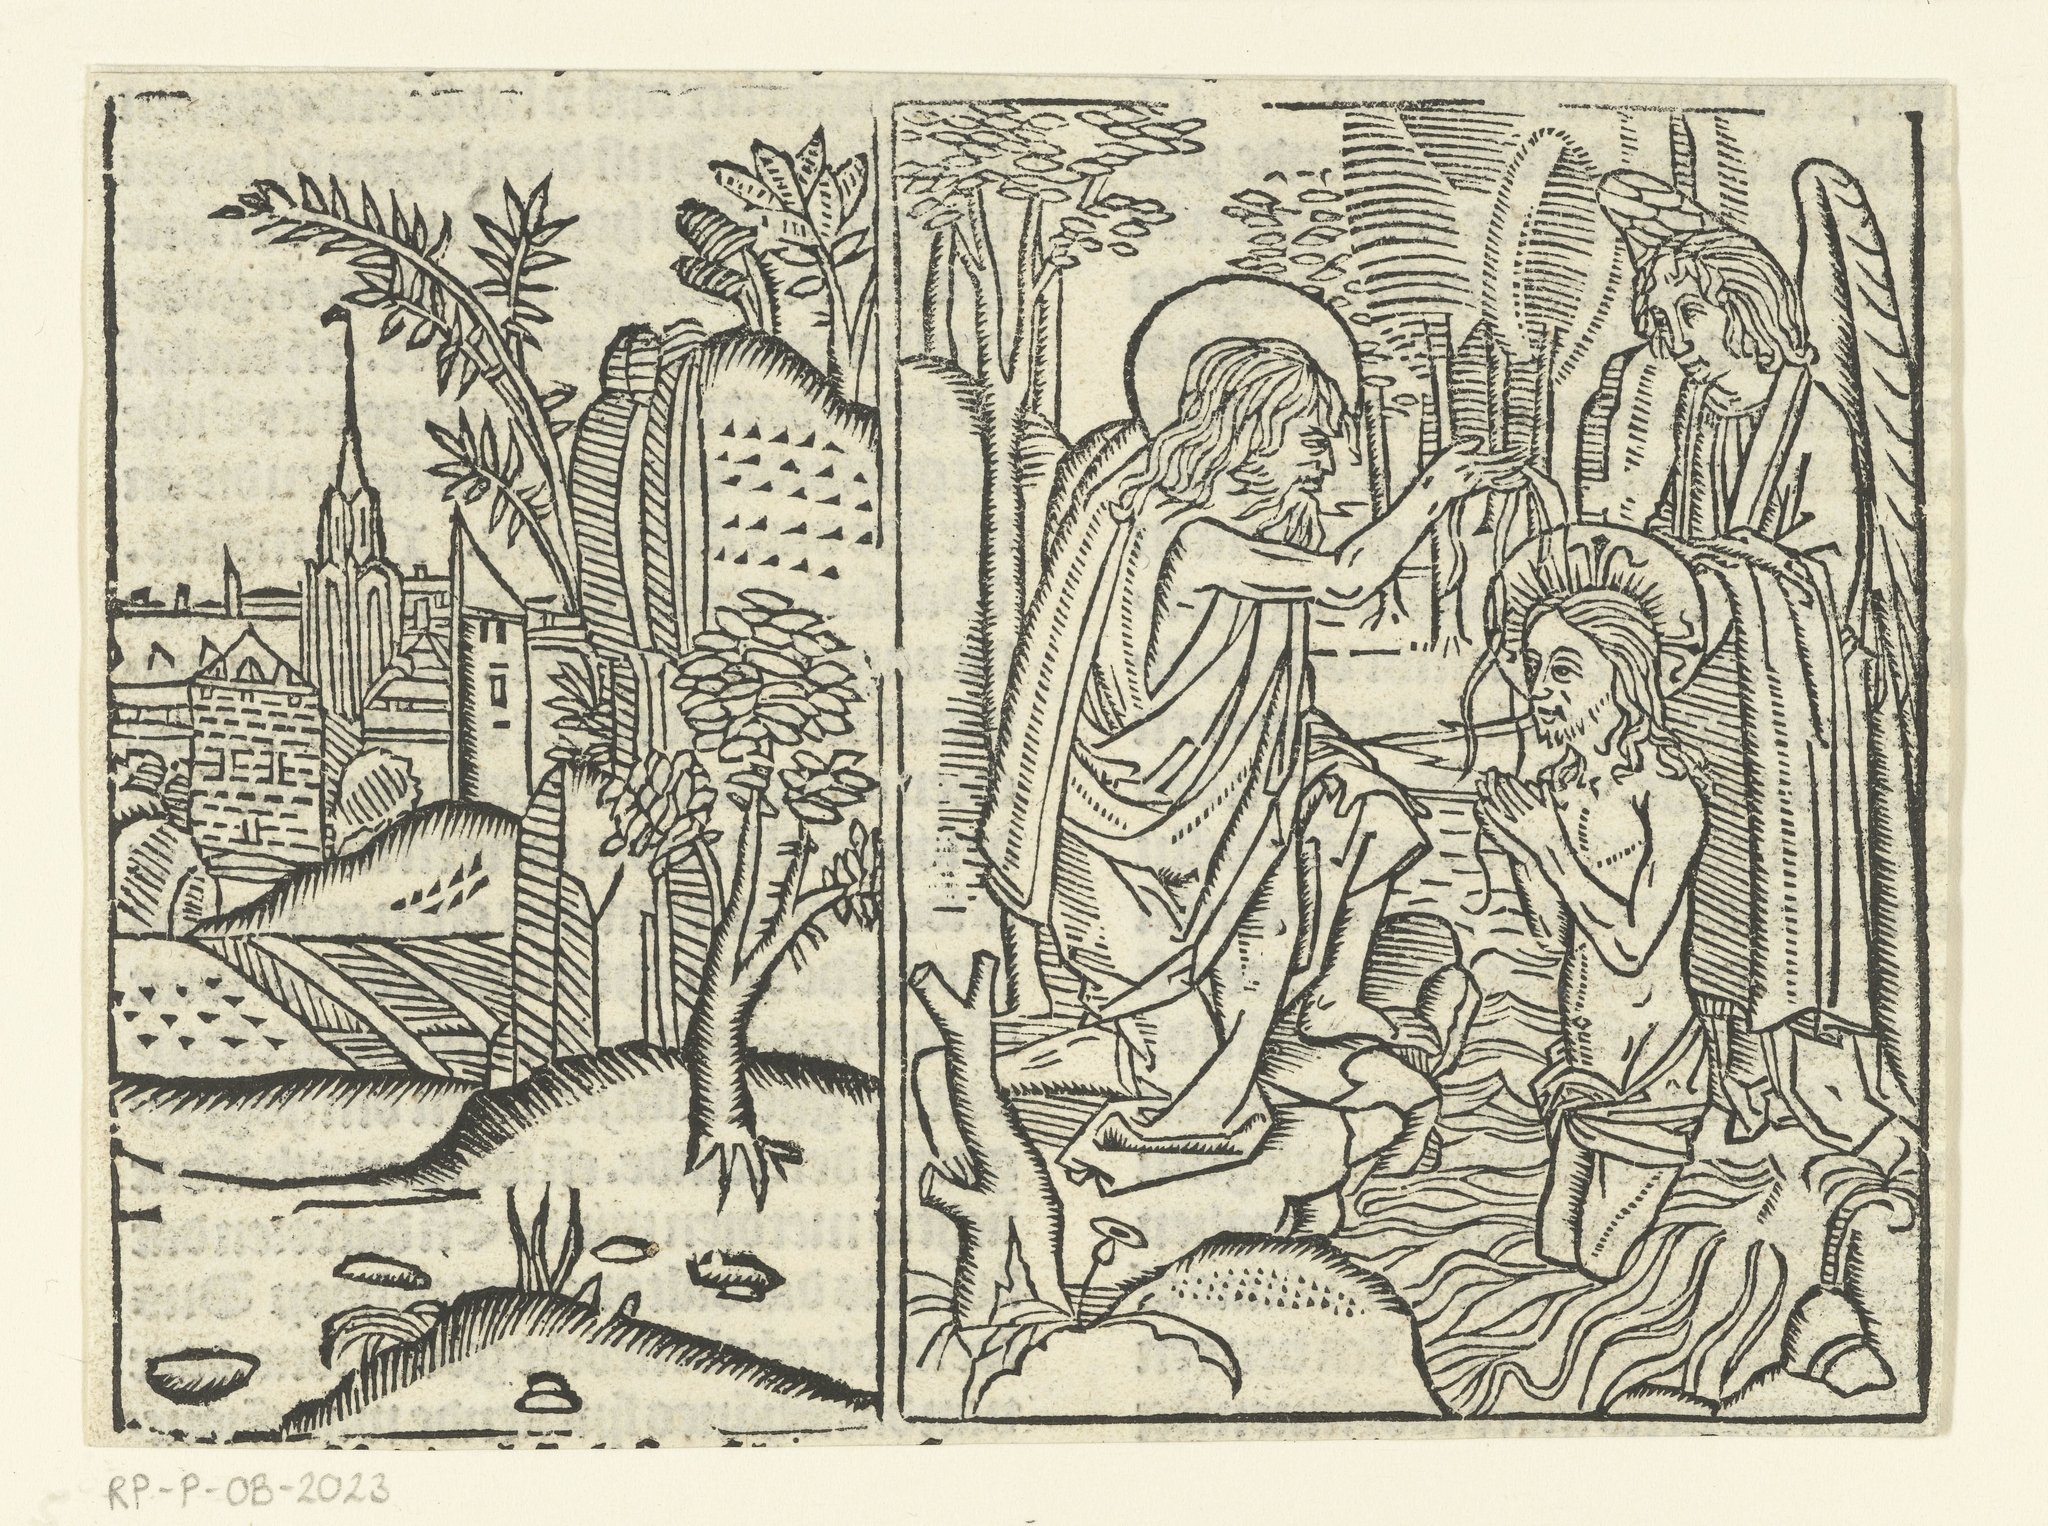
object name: print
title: De doop van Christus in de Jordaan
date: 1480-1500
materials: paper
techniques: woodcut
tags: city-view, and landscape with man-made constructions, baptism of christ in the river jordan: john the baptist pouring out water on christ's head: the holy ghost descends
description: Eén blad van 113 uit Ludolphus de Saxonia, "Dit es dleué ons liefs heeren ihesu christi". Anonieme Nederlandse vertaling. Uitgegeven door Henrick Eckert van Homberch te Antwerpen in 1503. Botke, K. Deze 113 houtsneden, die meestal reeds in vroege Nederlandse boeken gebruikt zijn, worden toegeschreven aan de tweede Meester van Delft, de Meester van de Delbecq-Schreiber-passie en de Meester van de Virgo inter Virgines. In Conway (1884) en in "De gulden passer"(1951) zijn ook eerdere versies opgenomen. Botke, K.